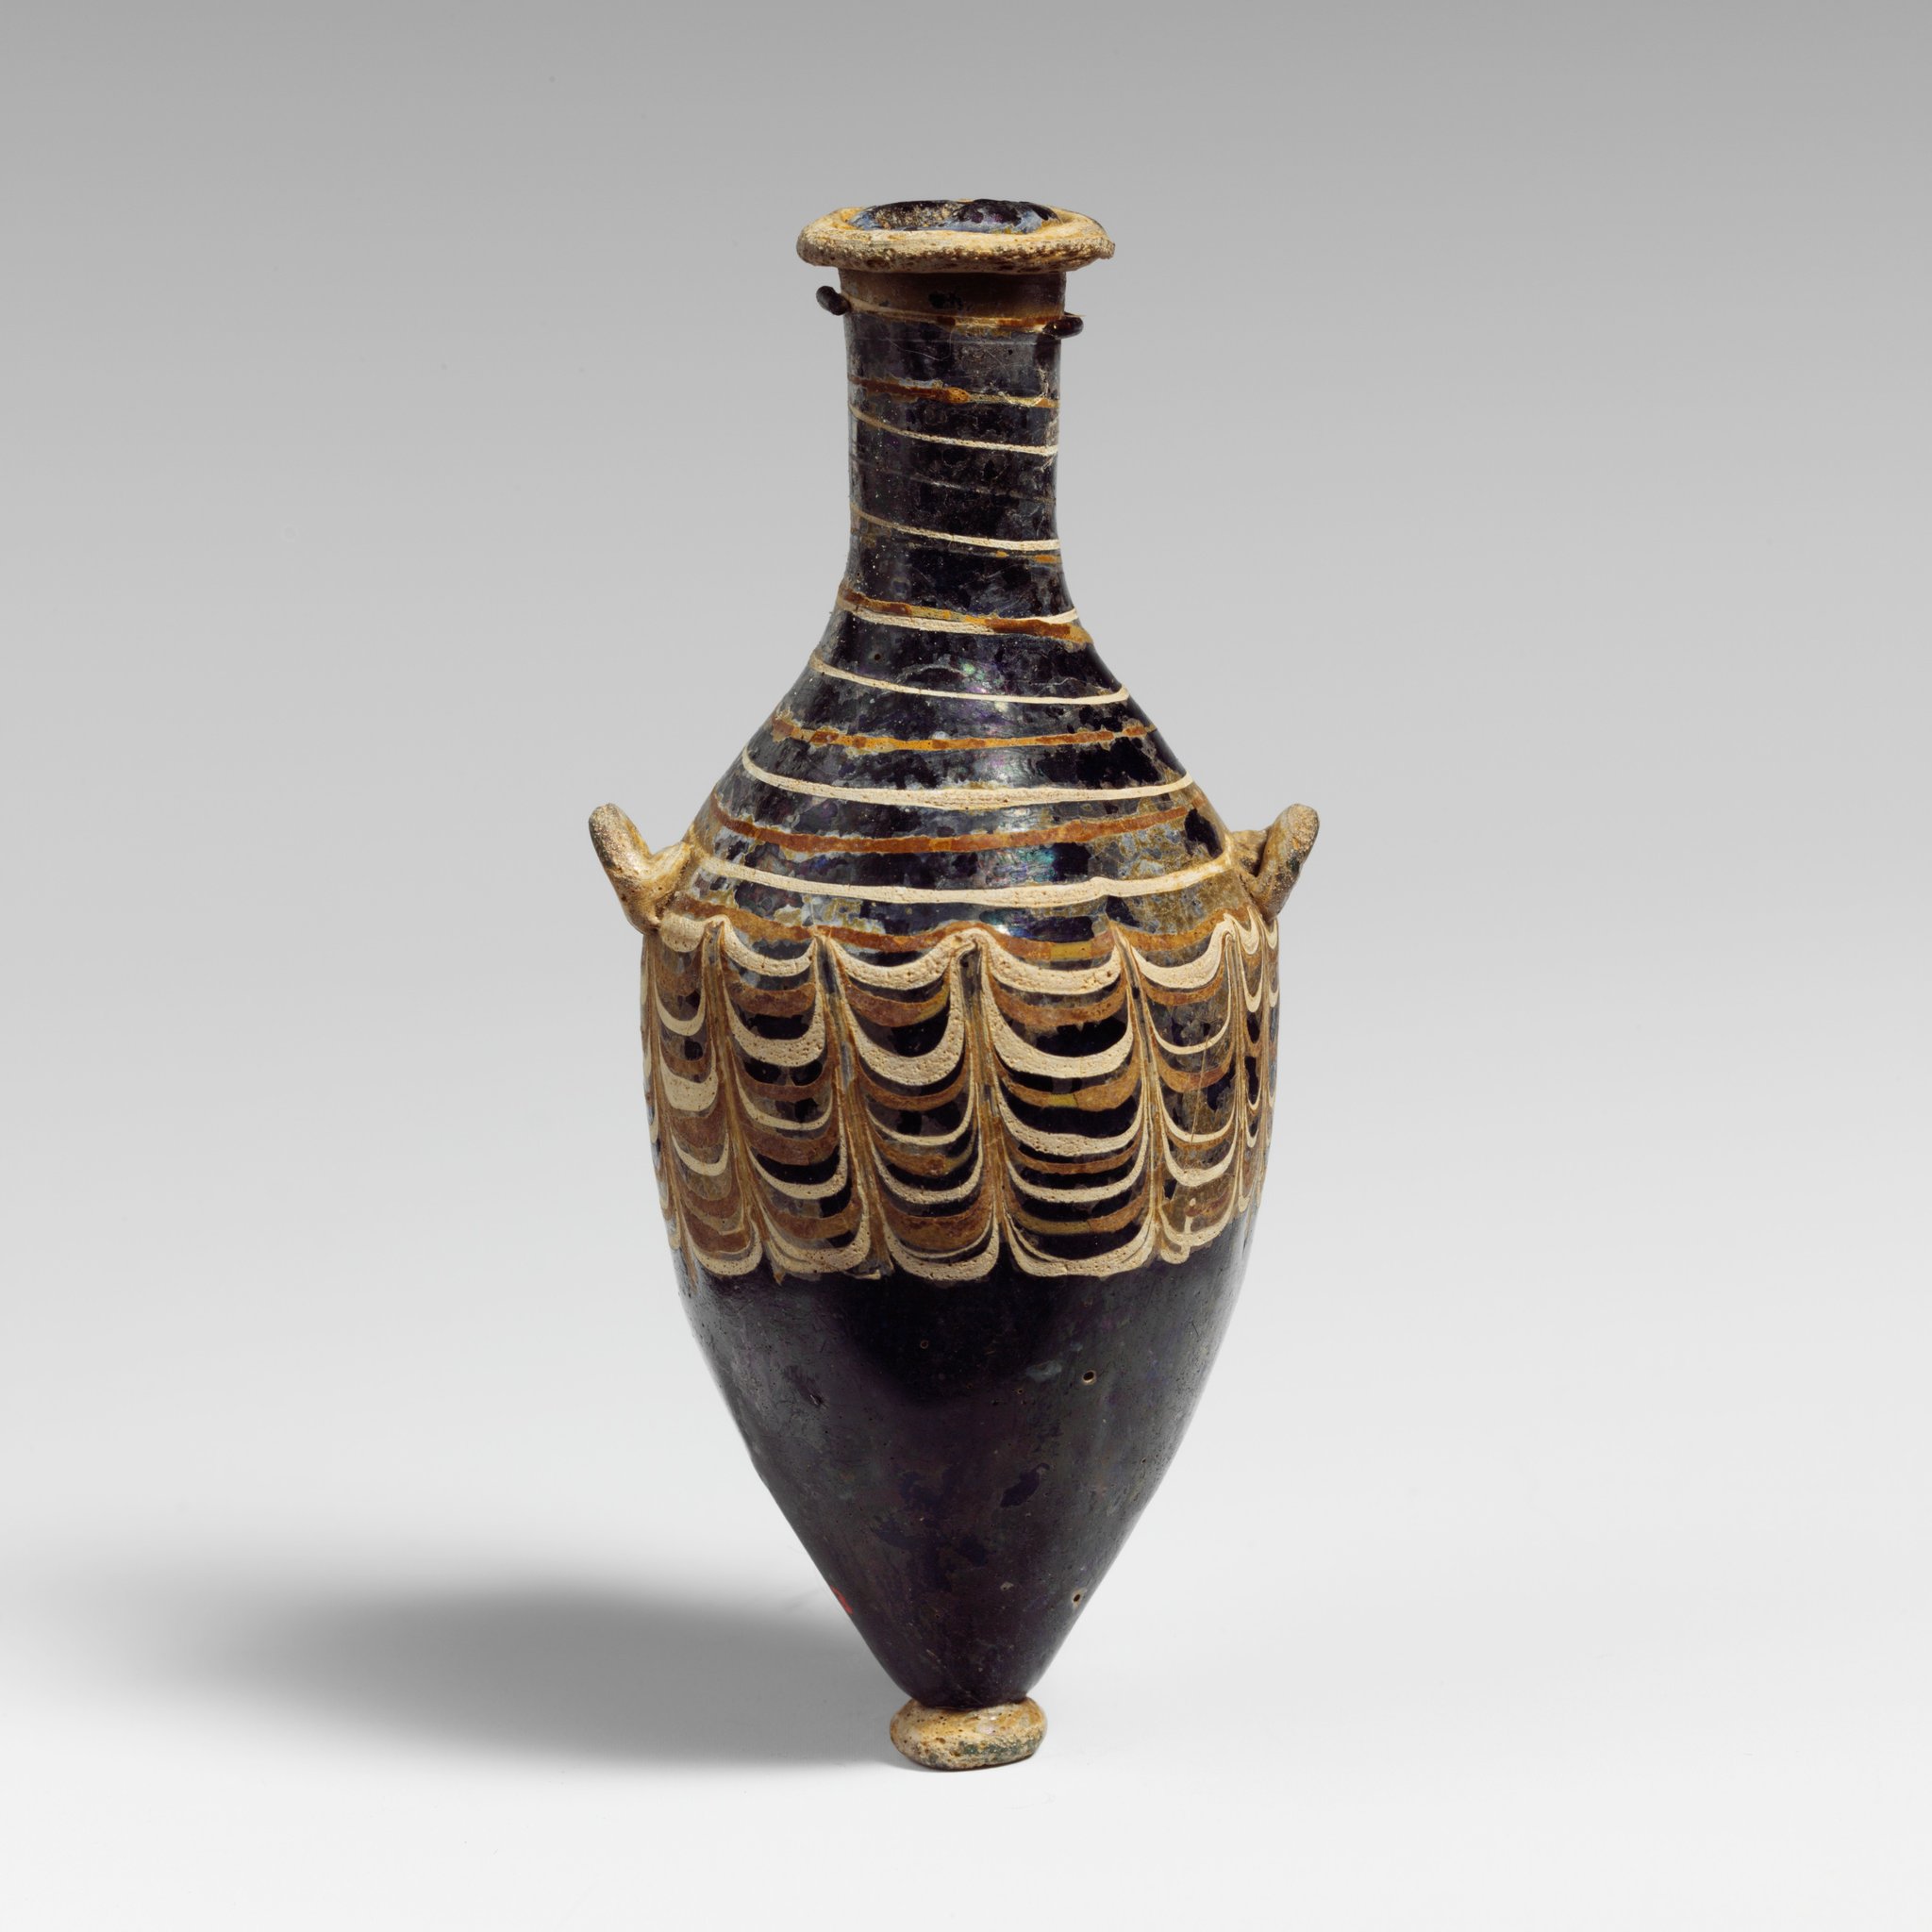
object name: unguentarium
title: Glass unguentarium (perfume bottle)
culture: greek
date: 300-201 BCE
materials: glass